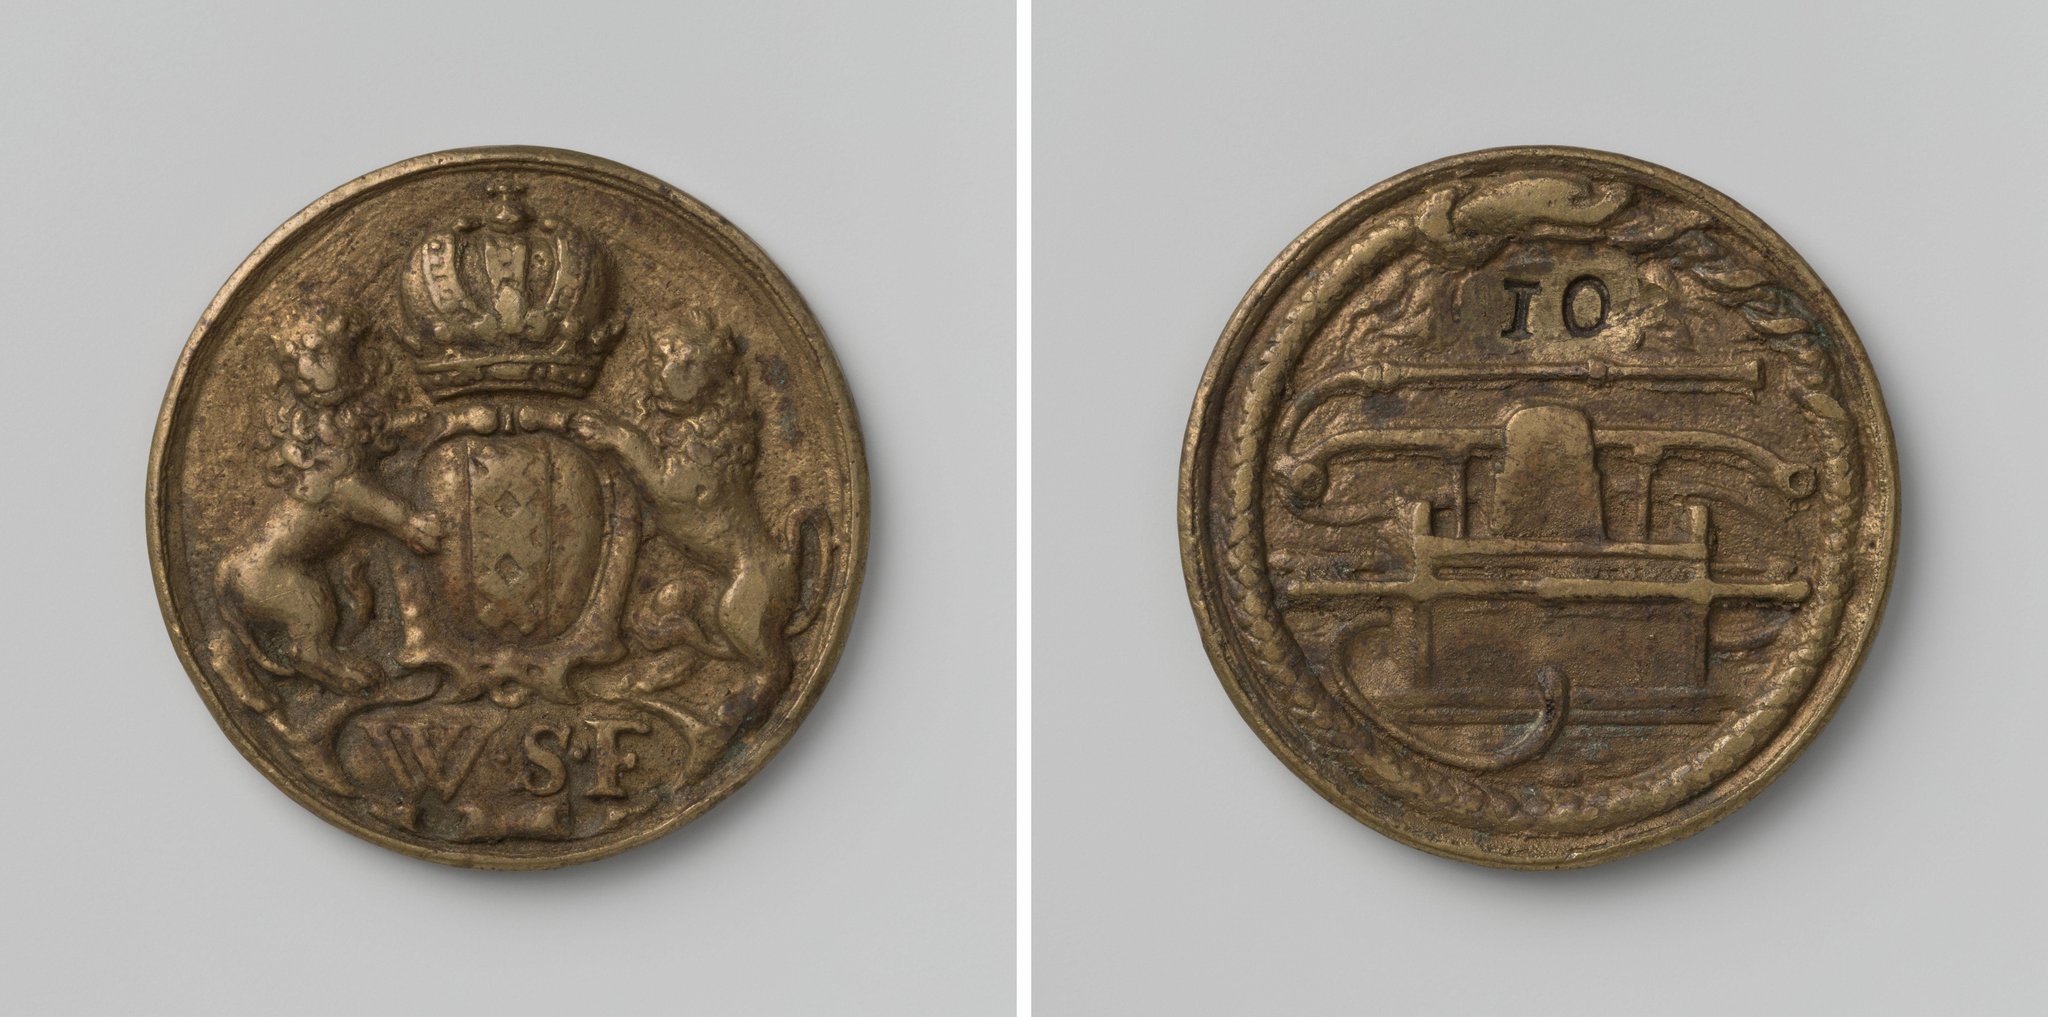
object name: fire engine medal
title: Amsterdam, brandspuitpenning met no. 10 en monogram W.S.F.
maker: Anonymous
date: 1680-1800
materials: brass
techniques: casting, engraving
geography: amsterdam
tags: amsterdam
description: Messing penning. Voorzijde: gekroond wapenschild, geflankeerd door twee leeuwen boven cartouche met opschrift W.S.F.. Keerzijde: brandspuit onder cartouche met no. 10 binnen slangerond